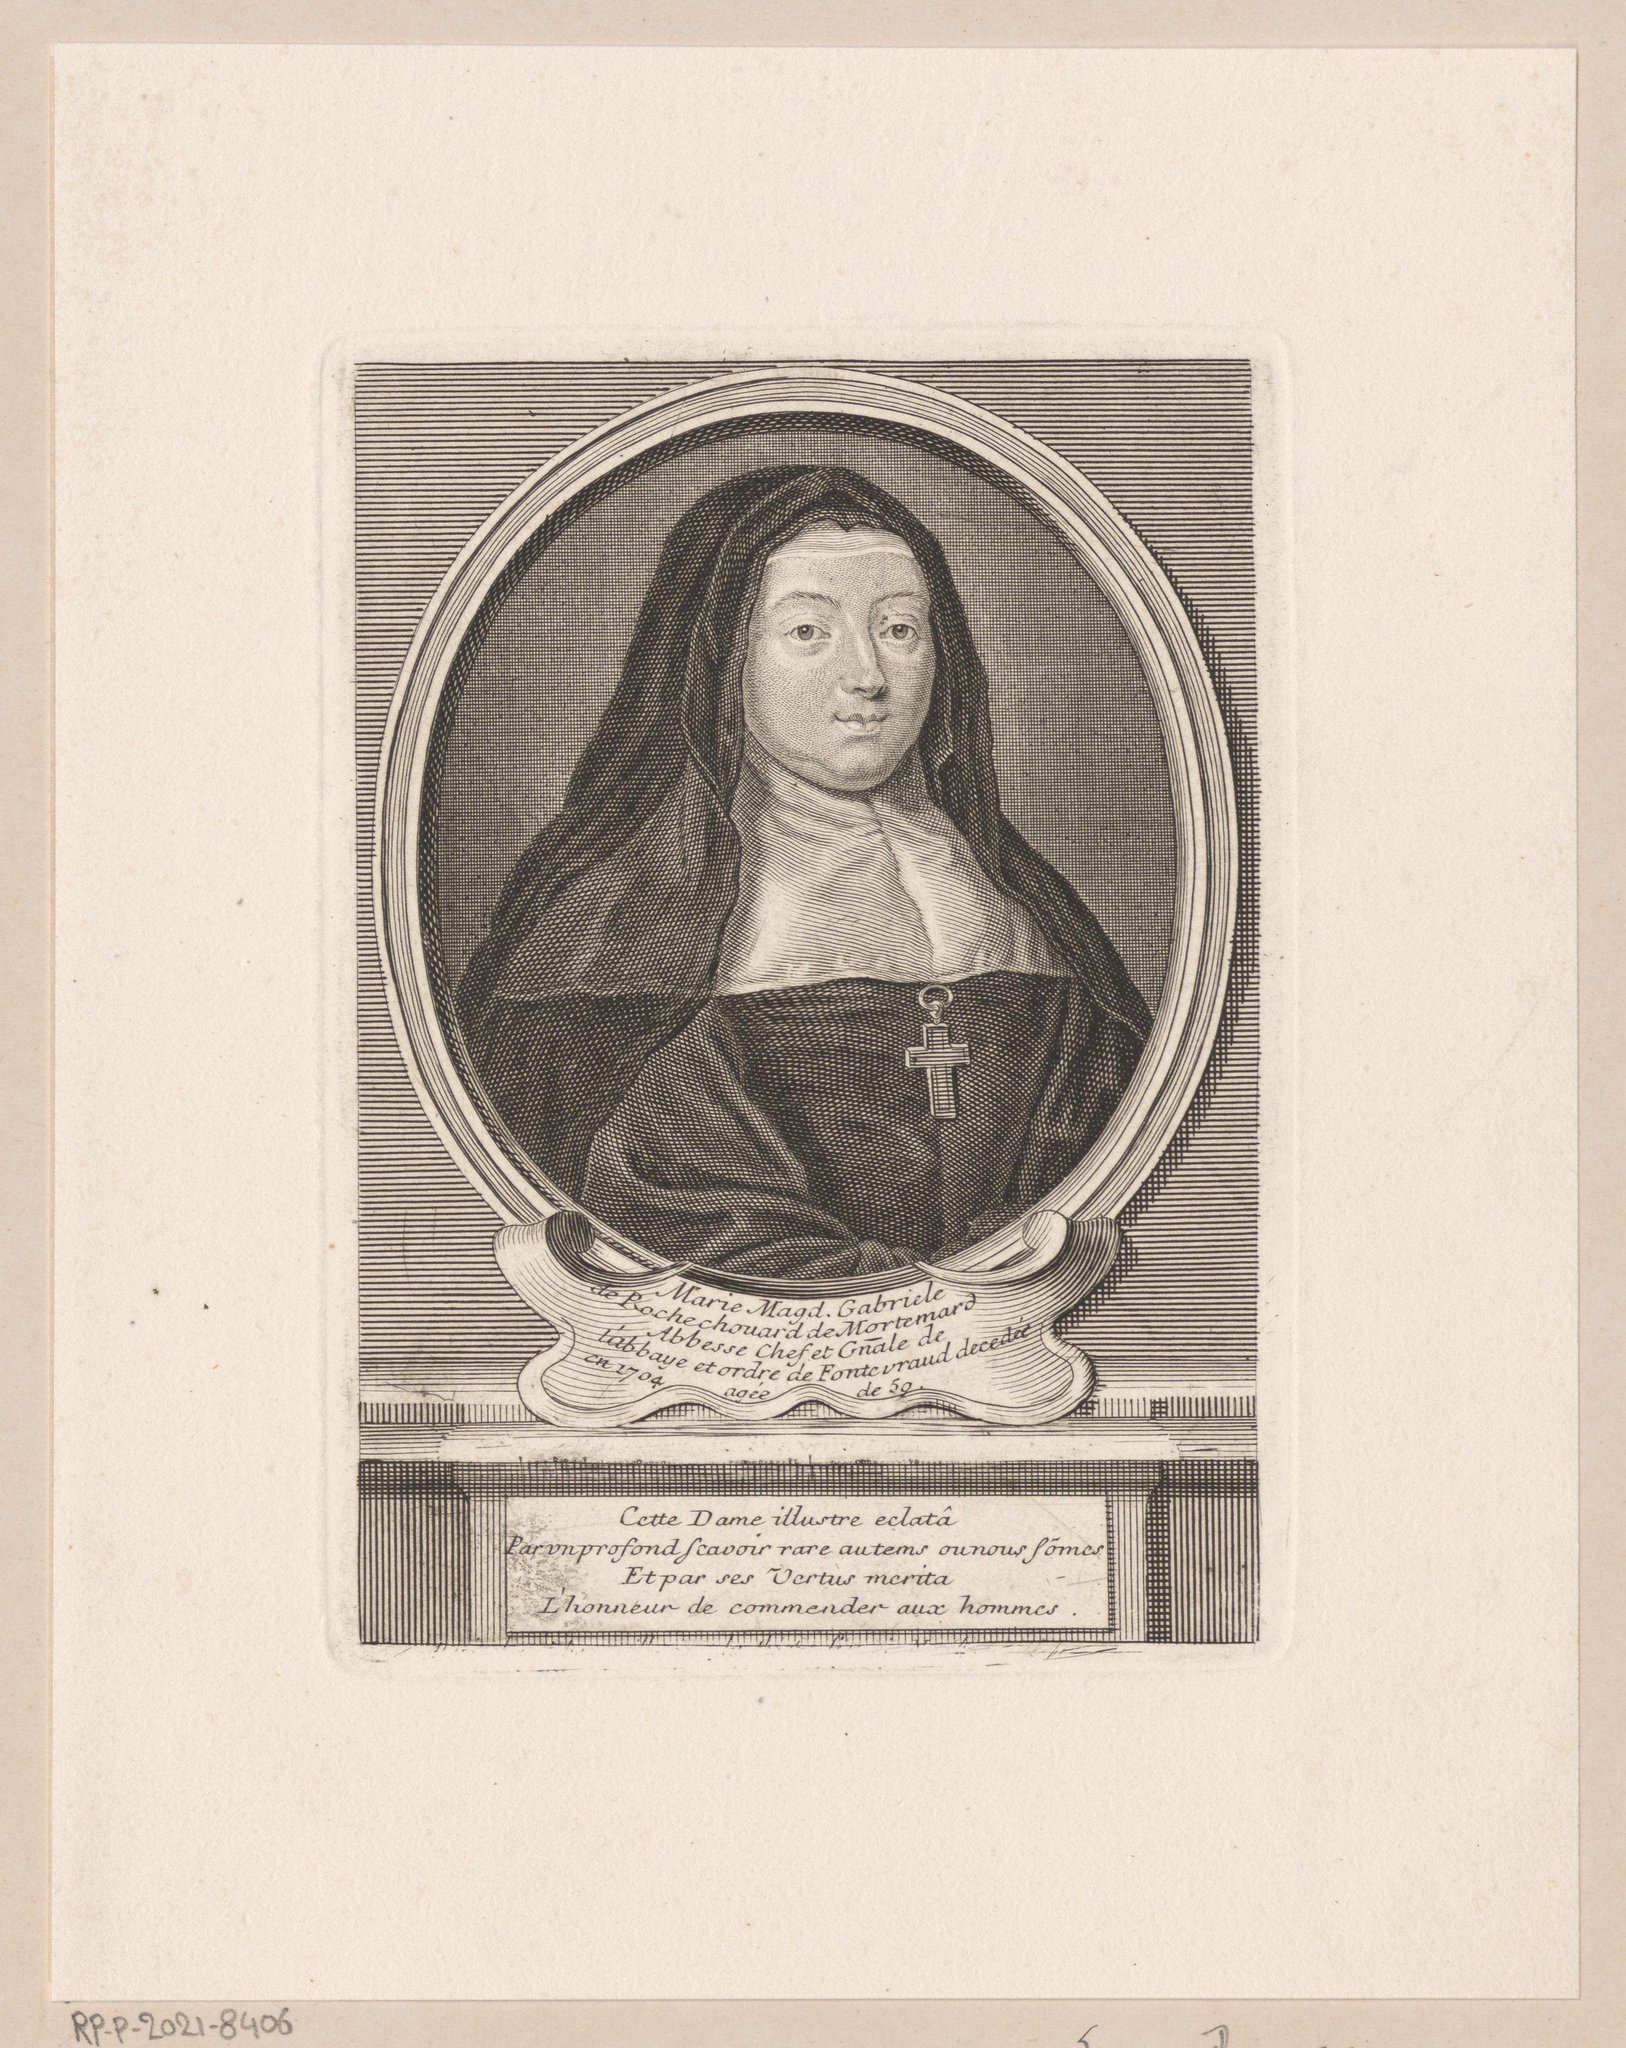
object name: print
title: Portret van Gabrielle de Rochechouart de Mortemart op 59-jarige leeftijd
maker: étienne desrochers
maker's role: print maker, publisher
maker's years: 1668-1741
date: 1704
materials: paper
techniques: engraving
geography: paris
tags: historical persons - bb - woman, nun(s)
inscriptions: date